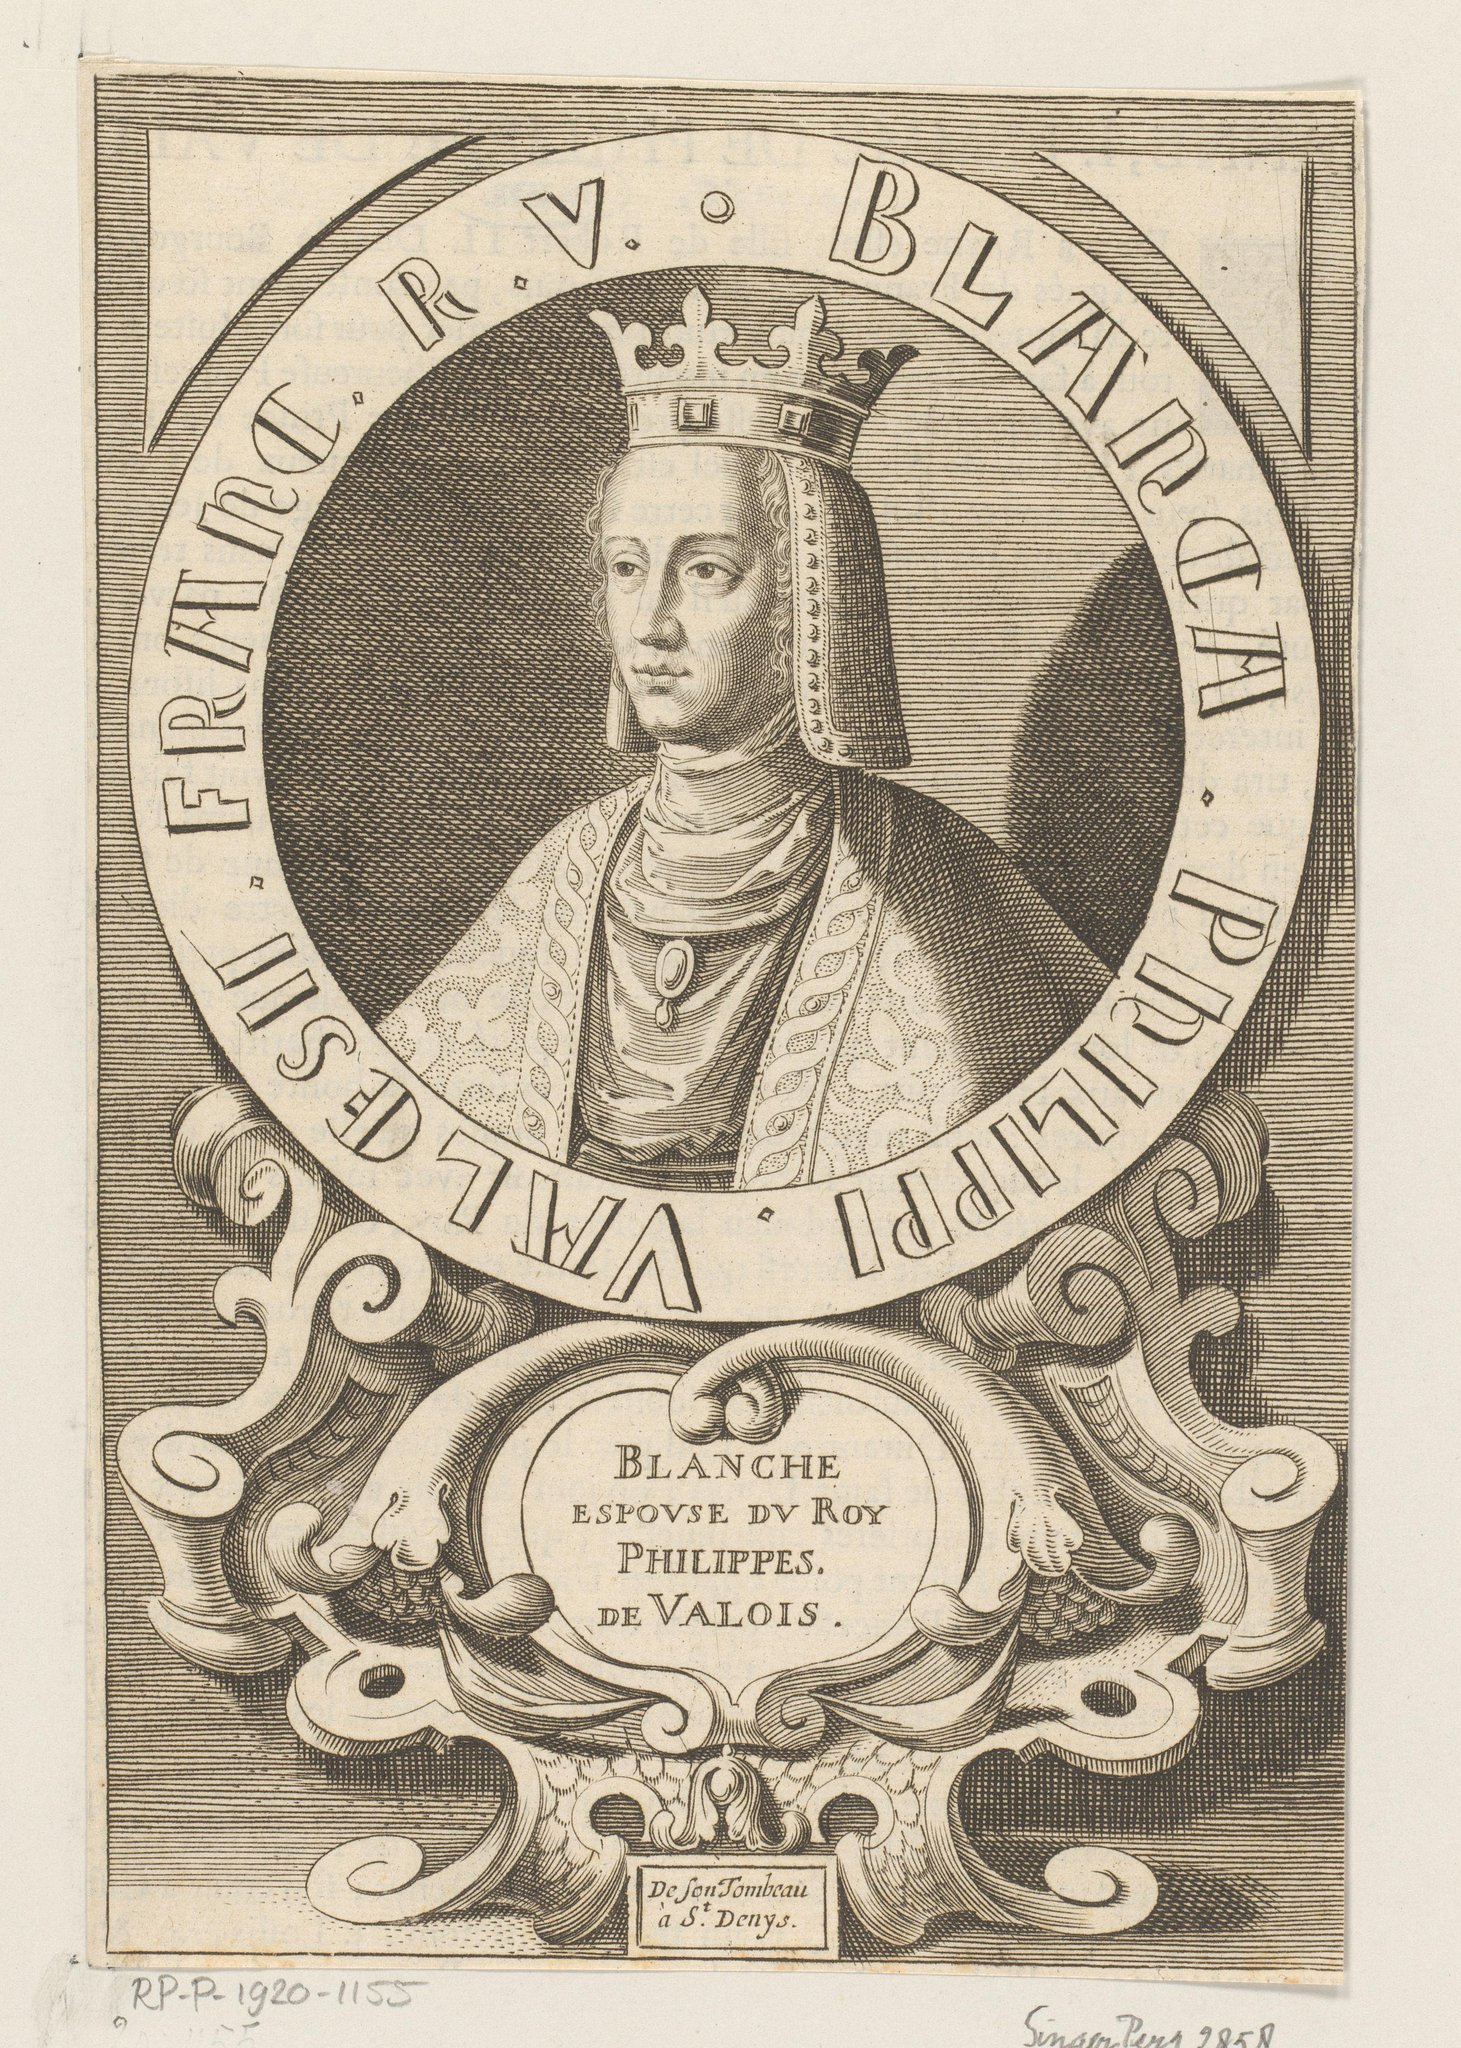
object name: book illustration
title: Portret van Blanca I van Navarra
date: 1635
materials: paper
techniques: engraving, letterpress printing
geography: paris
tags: historical persons, queen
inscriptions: collector's mark: Lugt 2228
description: Prent uit: Eudes de Mézeray, François. Histoire de France, depuis Faramond jusqu’au regne de Louis le Juste (...). 3 dln. Parijs: Denis Thierry, Jean Guignard en Claude Barbin, 1635, dl. 2. Prent waarschijnlijk voor het eerst verschenen in: Bie, Jacques de. Les vrais portraits des rois de France (...). Parijs: Jacques de Bie en Pierre Rocolet, 1634. Prent ook gebruikt in latere publicaties.